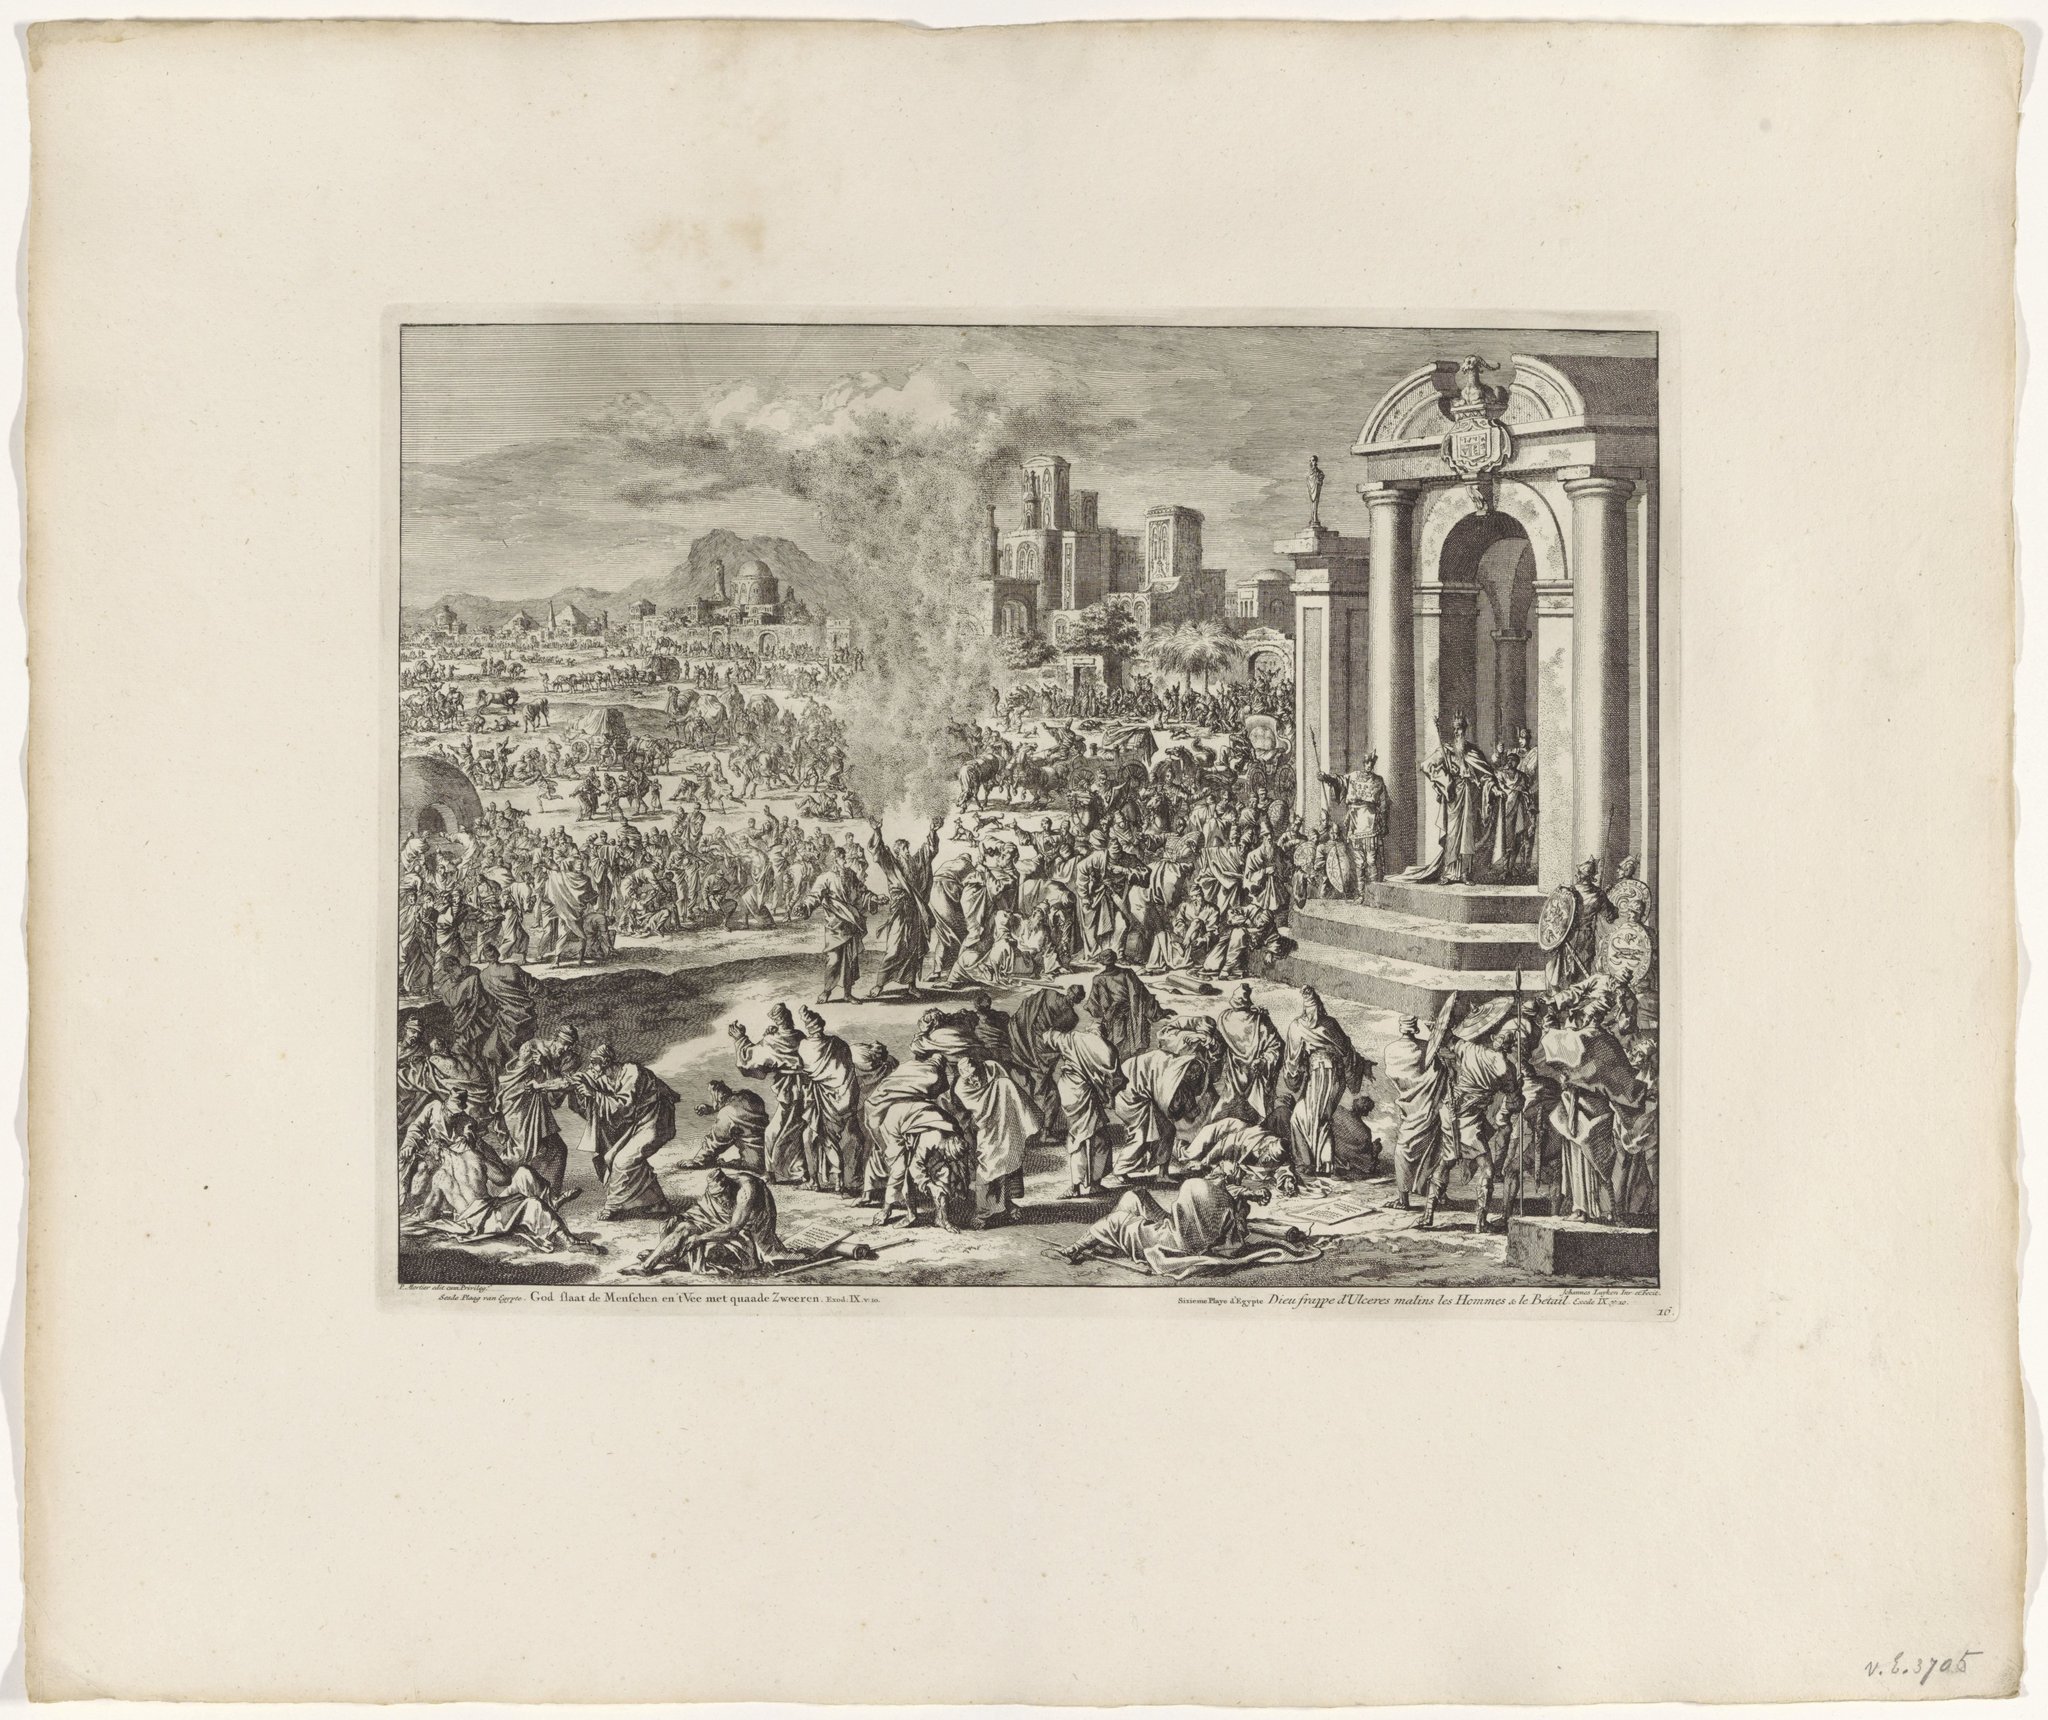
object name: book illustration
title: Sesde Plaag van Egypte. God slaat de Menschen en 't Vee met quaade Zweeren.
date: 1708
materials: paper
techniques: etching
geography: amsterdam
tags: the plague of boils: moses throws a handful of ashes into the air in front of pharaoh and it produces boils on the people and the animals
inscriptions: collector's mark: Lugt 2228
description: Op een plein voor de tempel waar de farao staat, gooit Mozes as omhoog temidden van een menigte mensen. De mensen krabben zich en tonen elkaar hun aangedane ledematen. De prent is een verbeelding van de zesde plaag die God over Egypte liet komen.